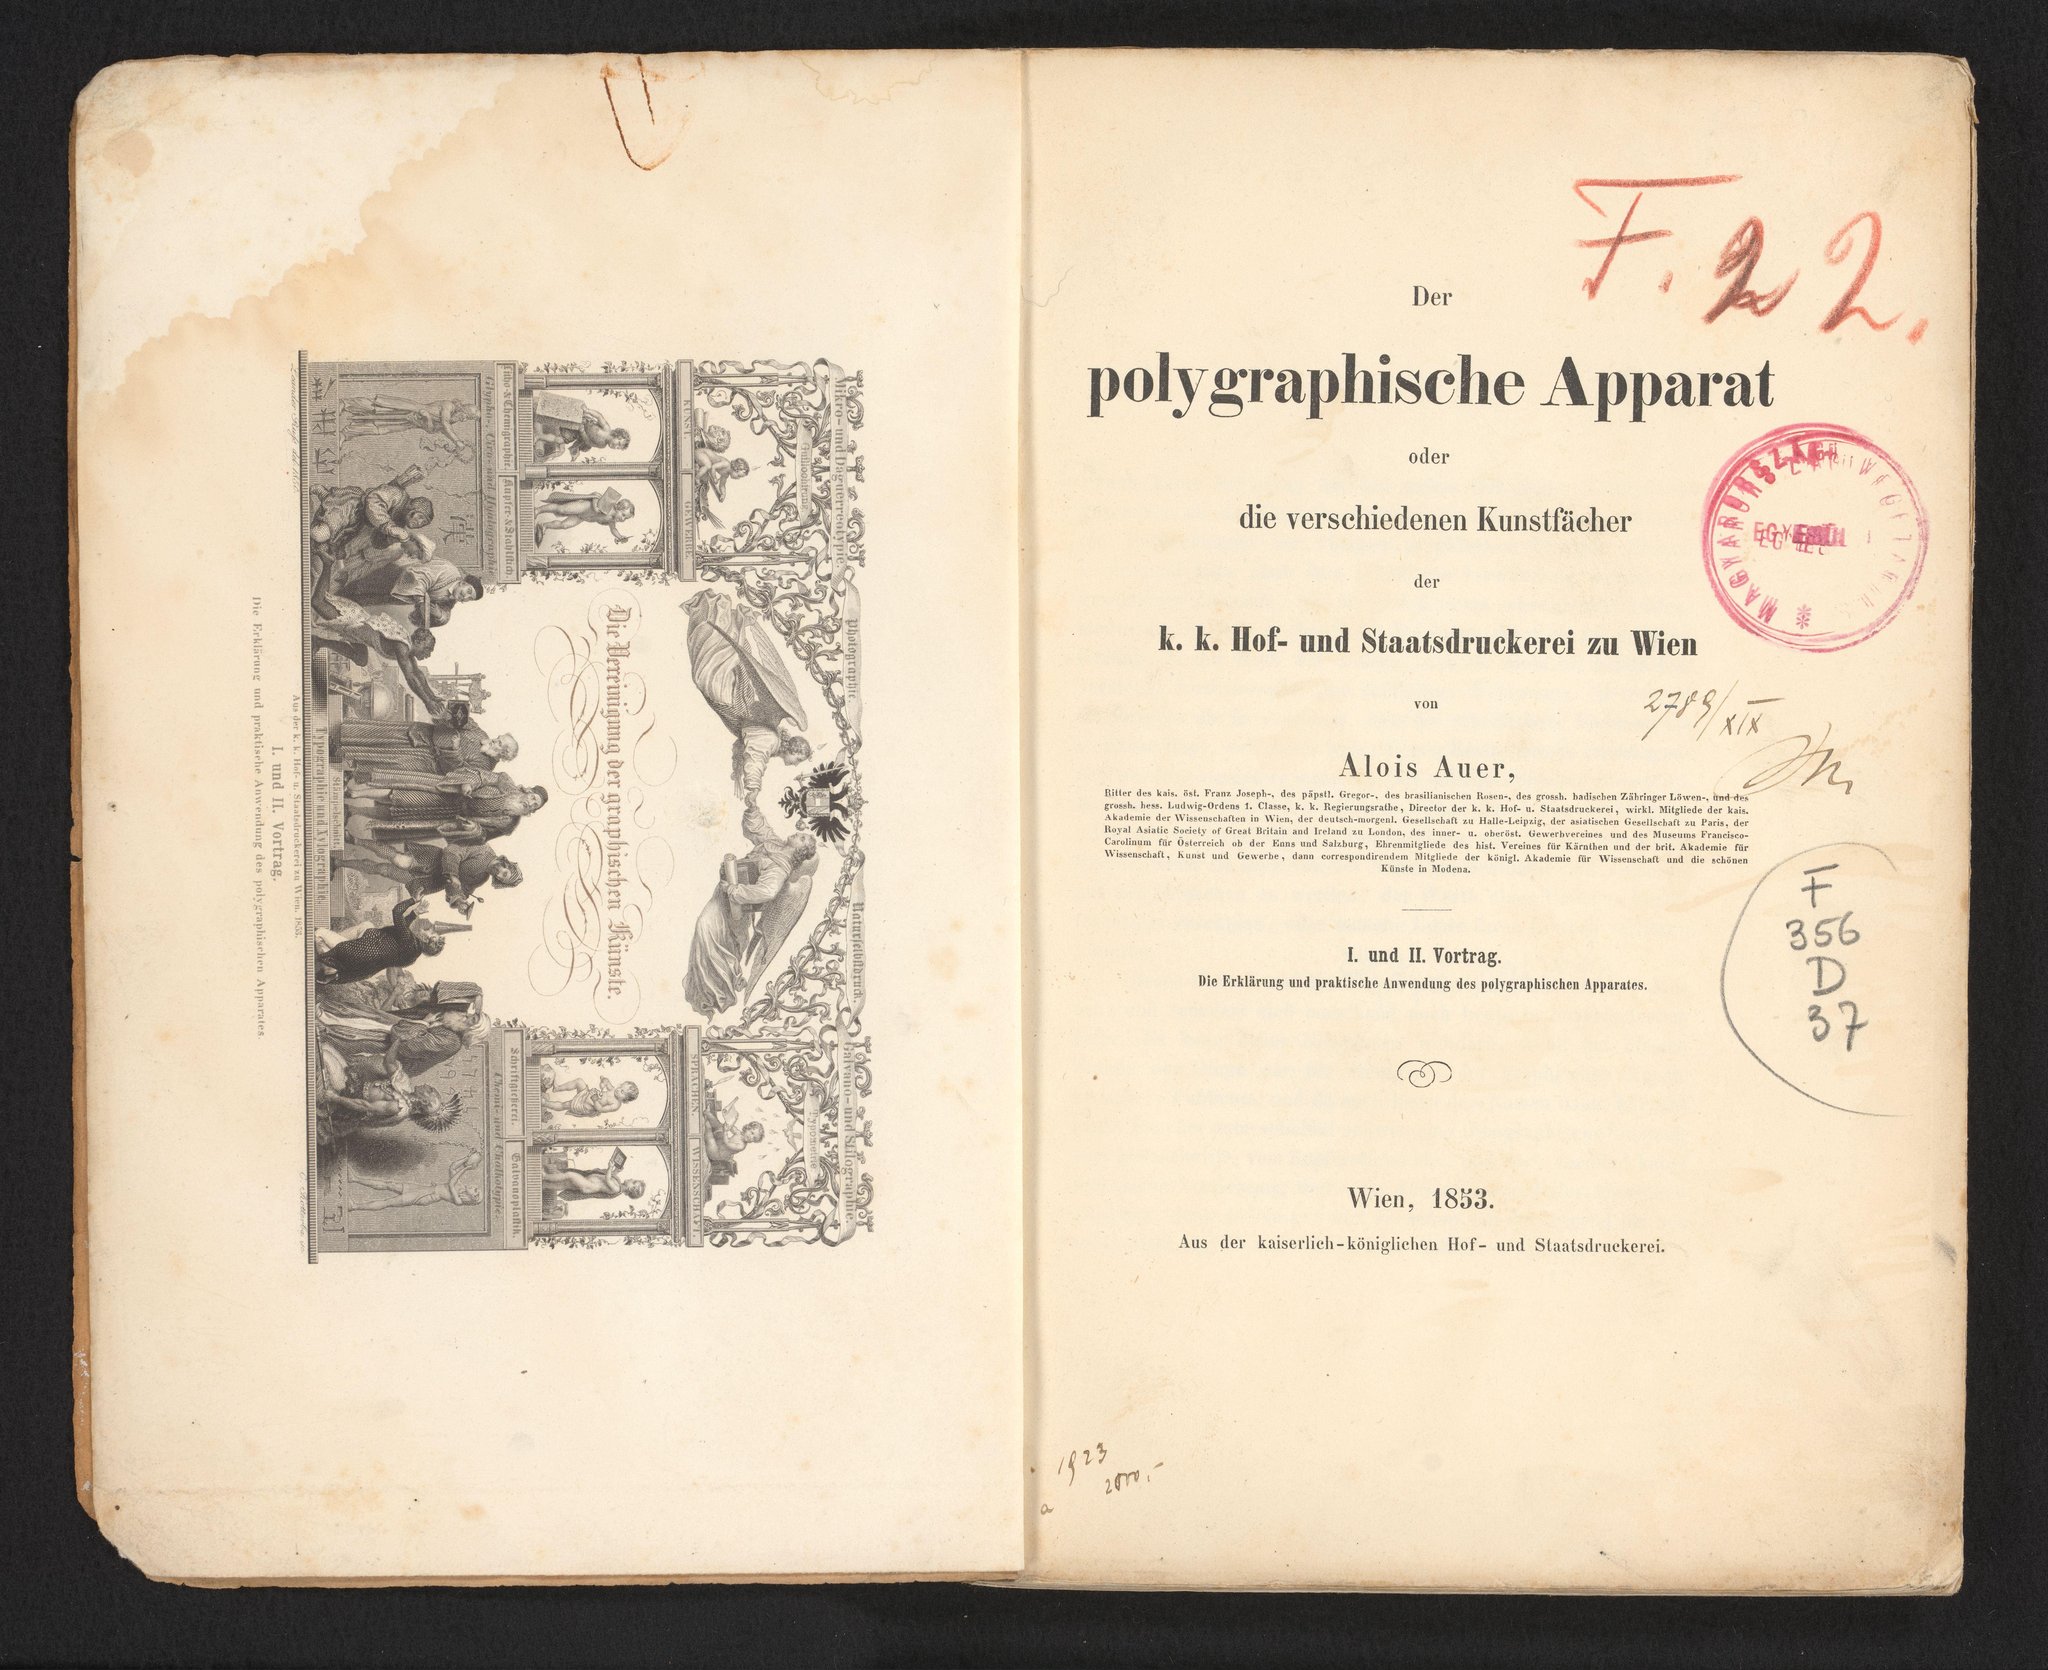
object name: book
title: Der polygraphische Apparat oder die verschiedenen Kunstfächer der k.k. Hof- und Staatsdruckerei zu Wien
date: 1853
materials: paper, photographic support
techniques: albumen print, engine turning, lithograph, printing, engraving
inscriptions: annotation